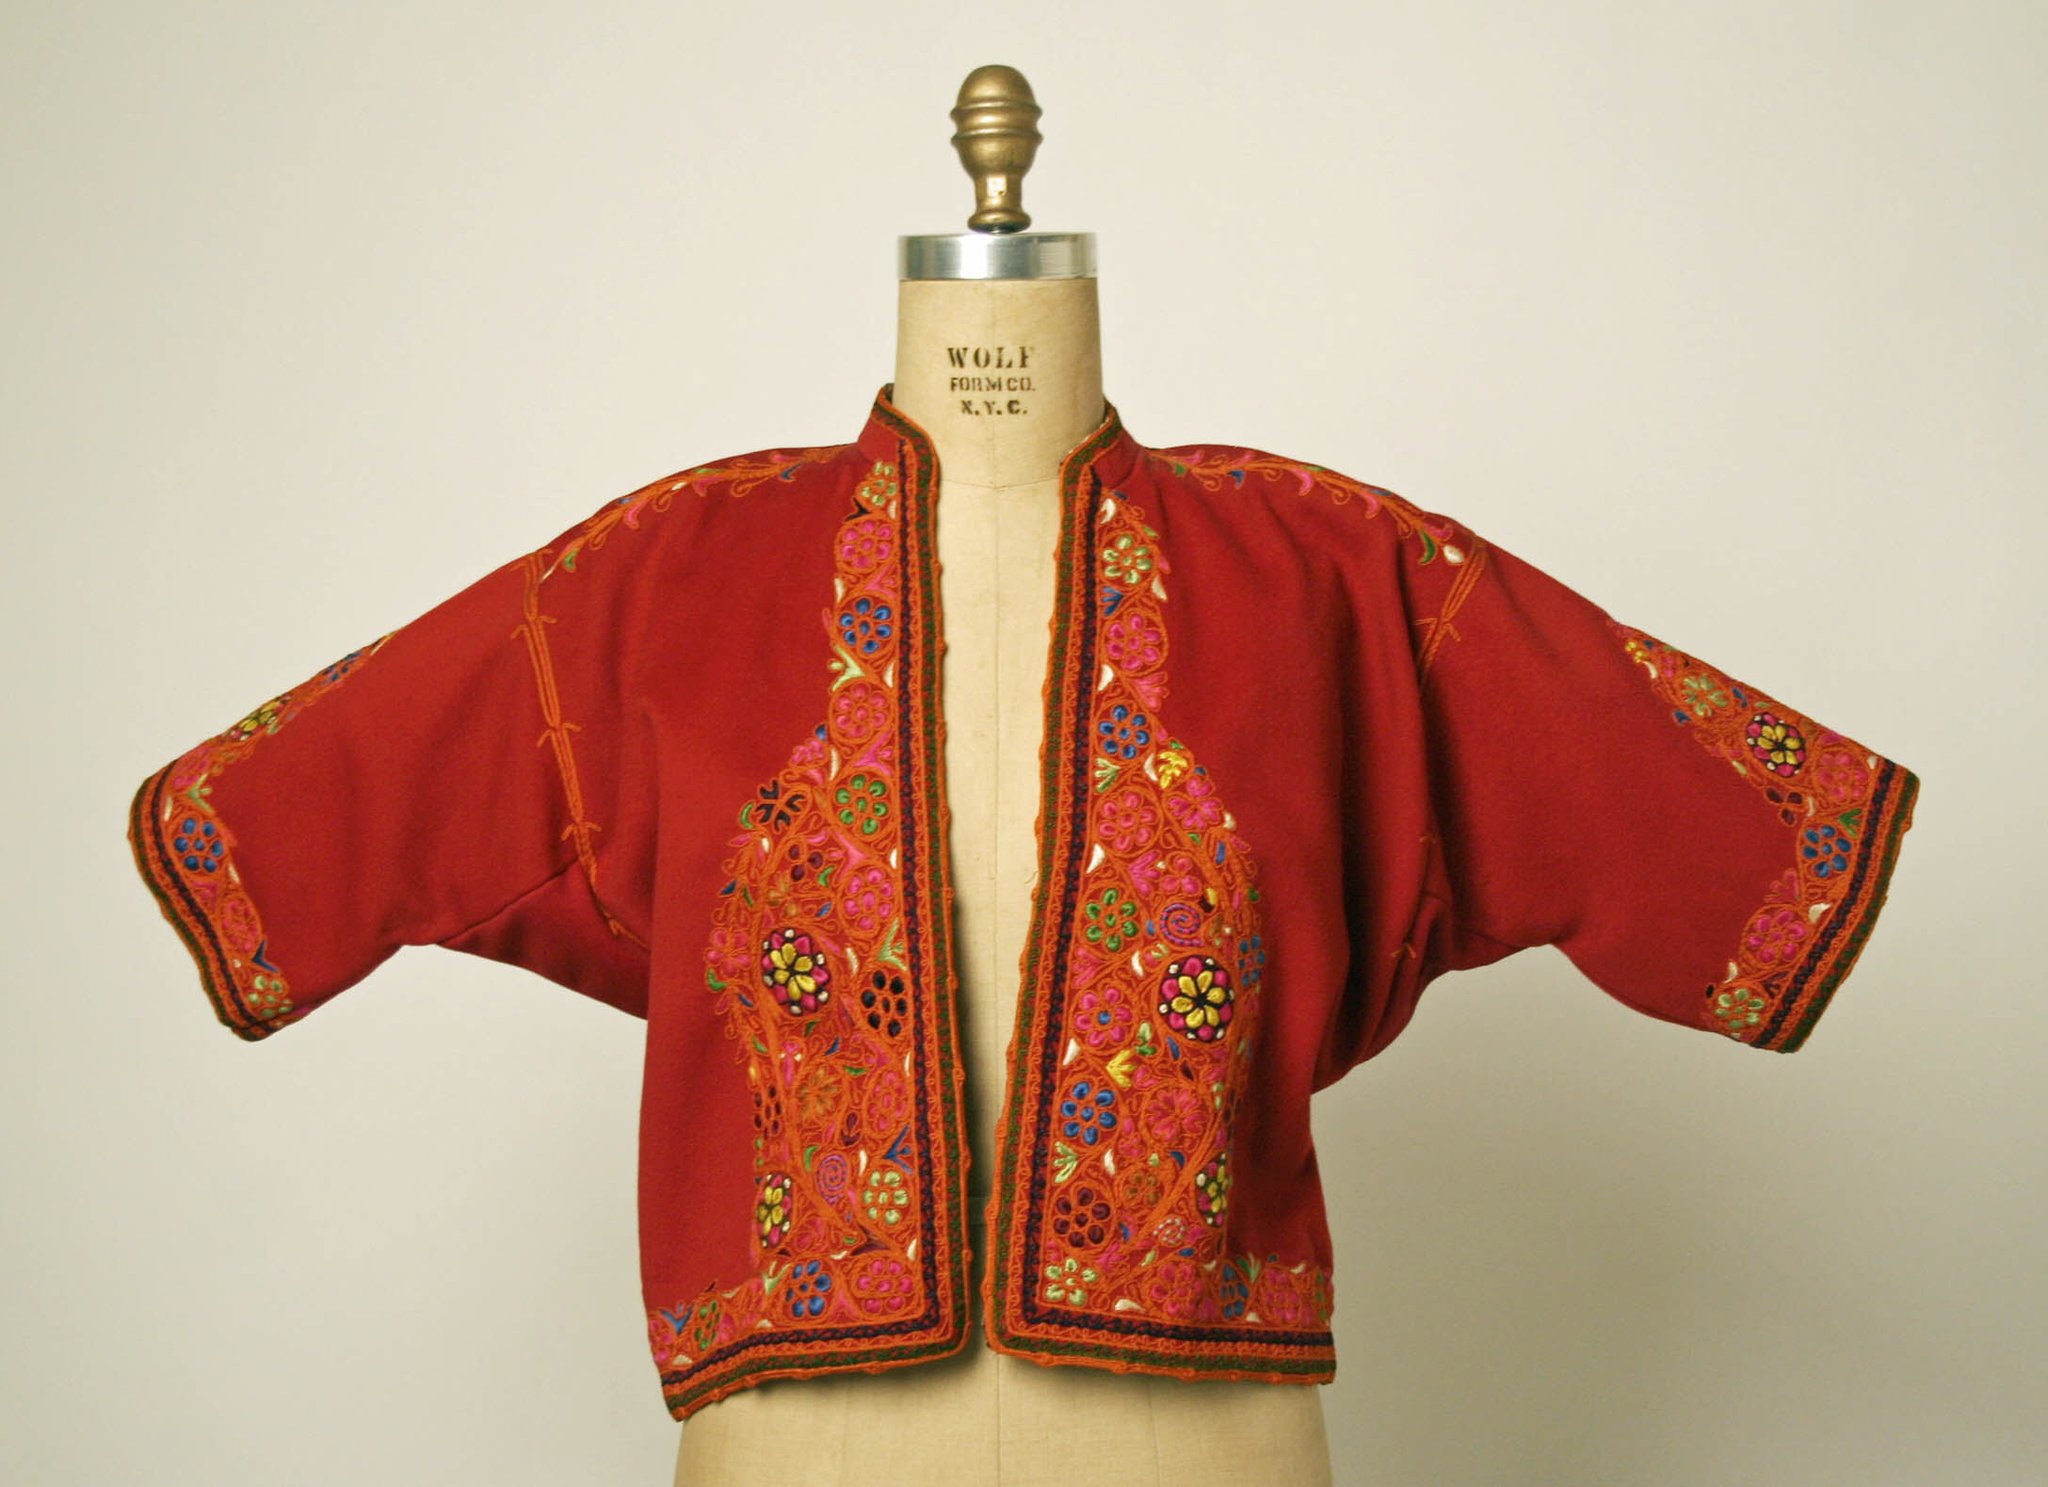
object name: jacket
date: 1801-1900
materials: silk, wool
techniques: embroidery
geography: palestine